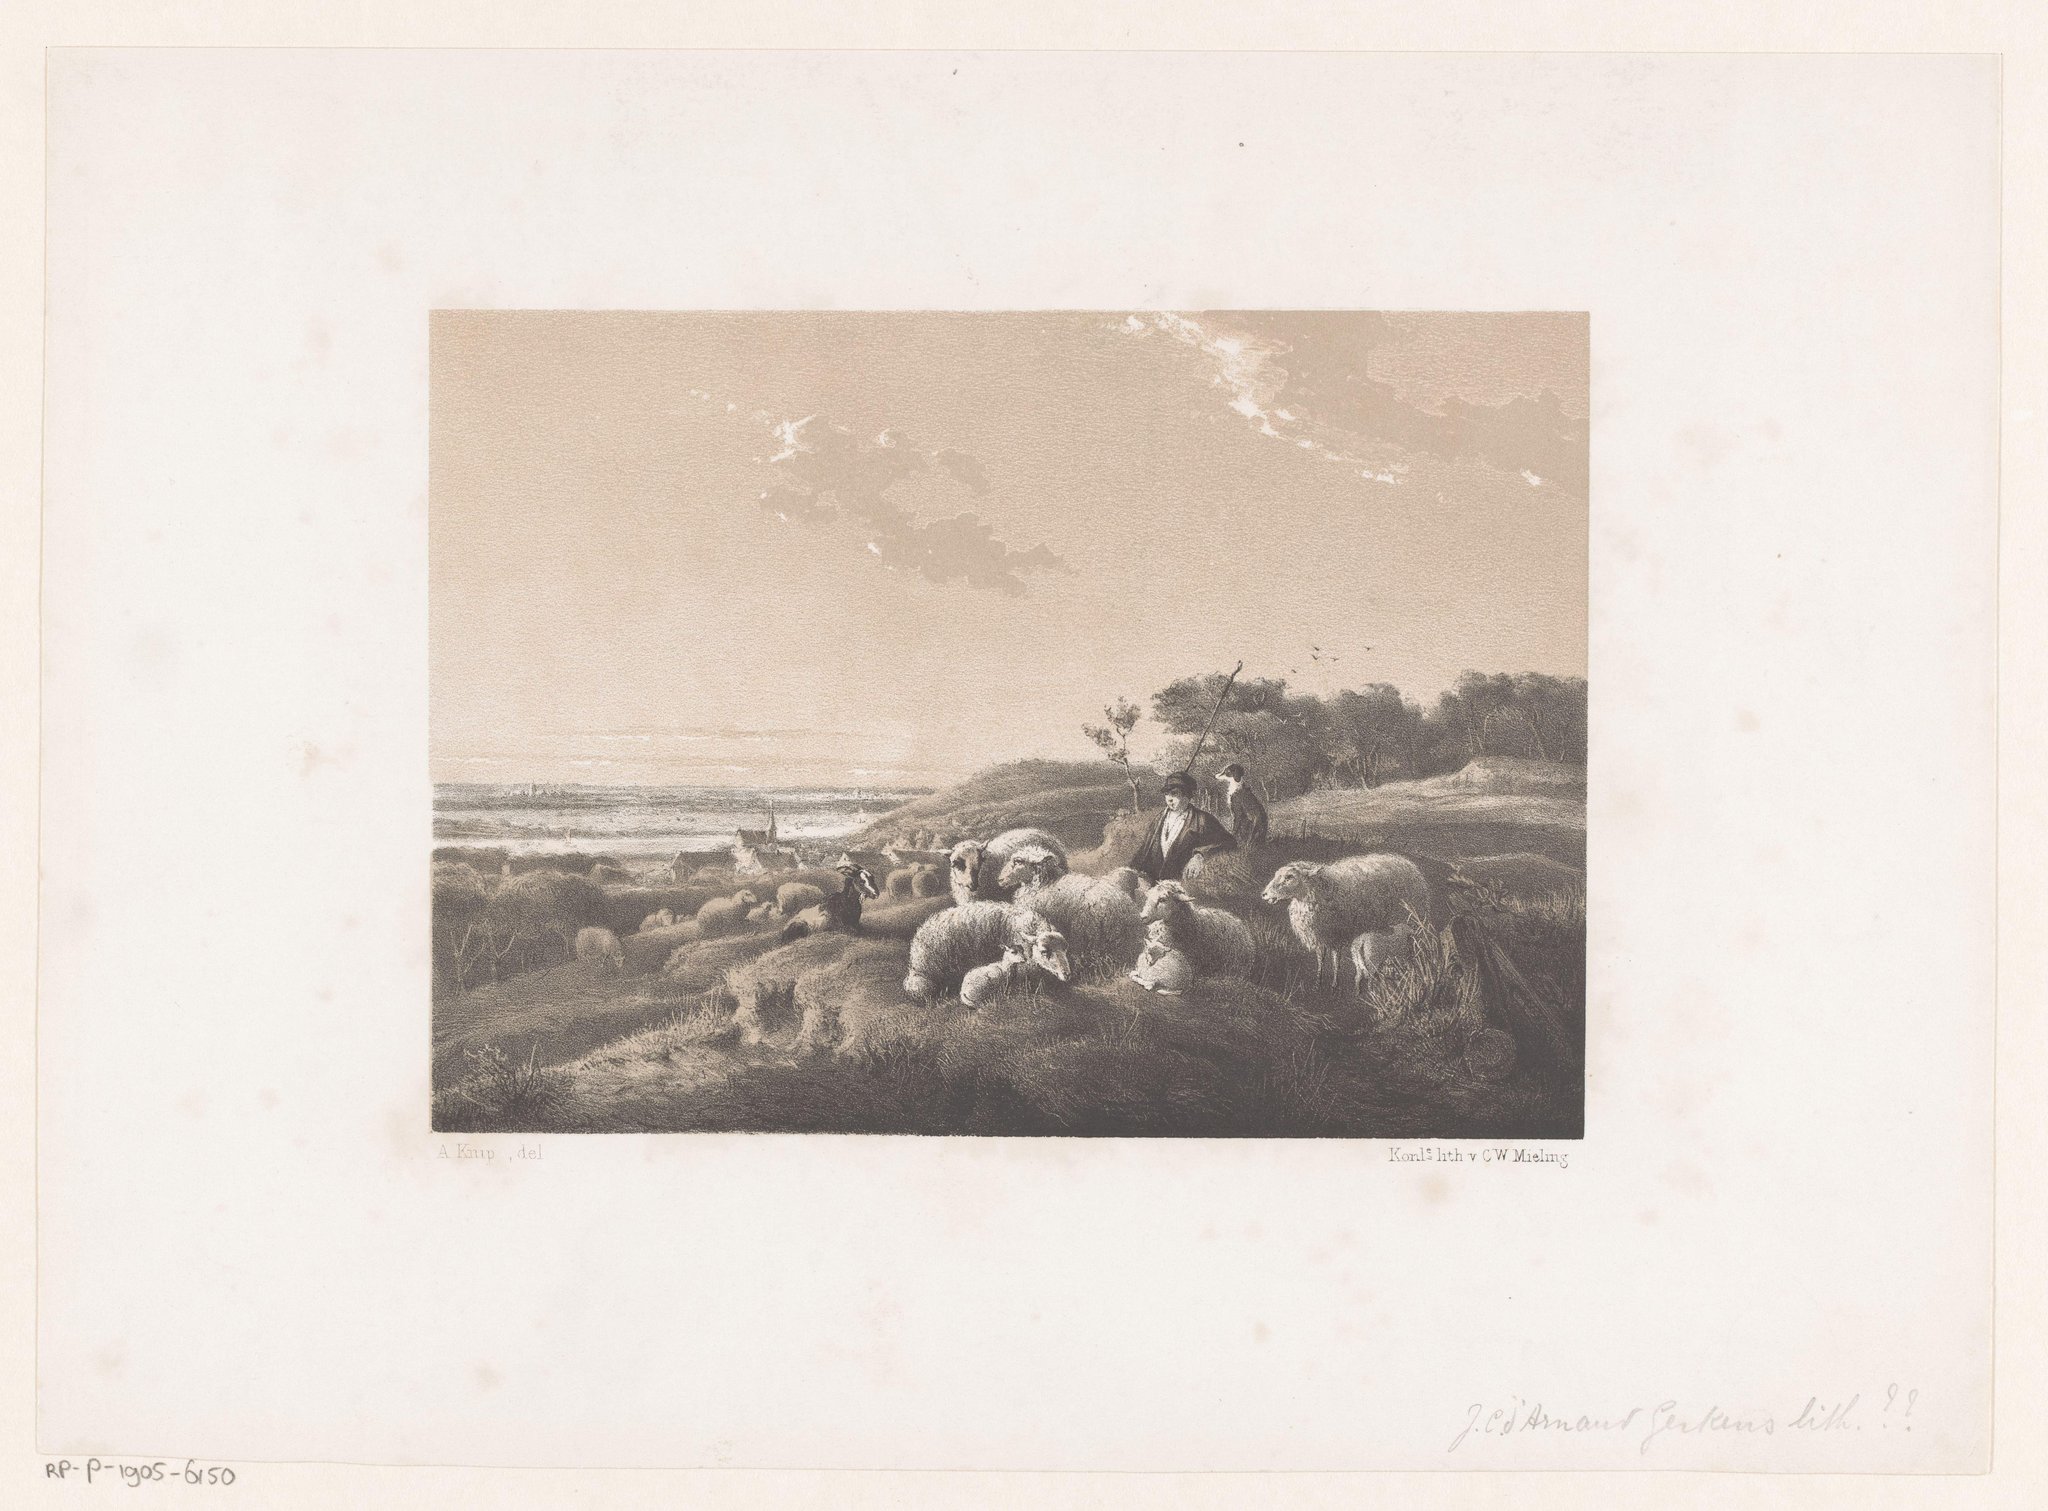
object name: print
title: Herder met kudde in de duinen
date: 1847-1863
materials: paper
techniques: tone lithography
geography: netherlands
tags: dune coast, herd, flock, sea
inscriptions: collector's mark: Lugt 2228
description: De herder zit in het gras met zijn hond naast zich. Voor hem zitten schapen en een geit. Verderop een dorp, het strand en de zee.